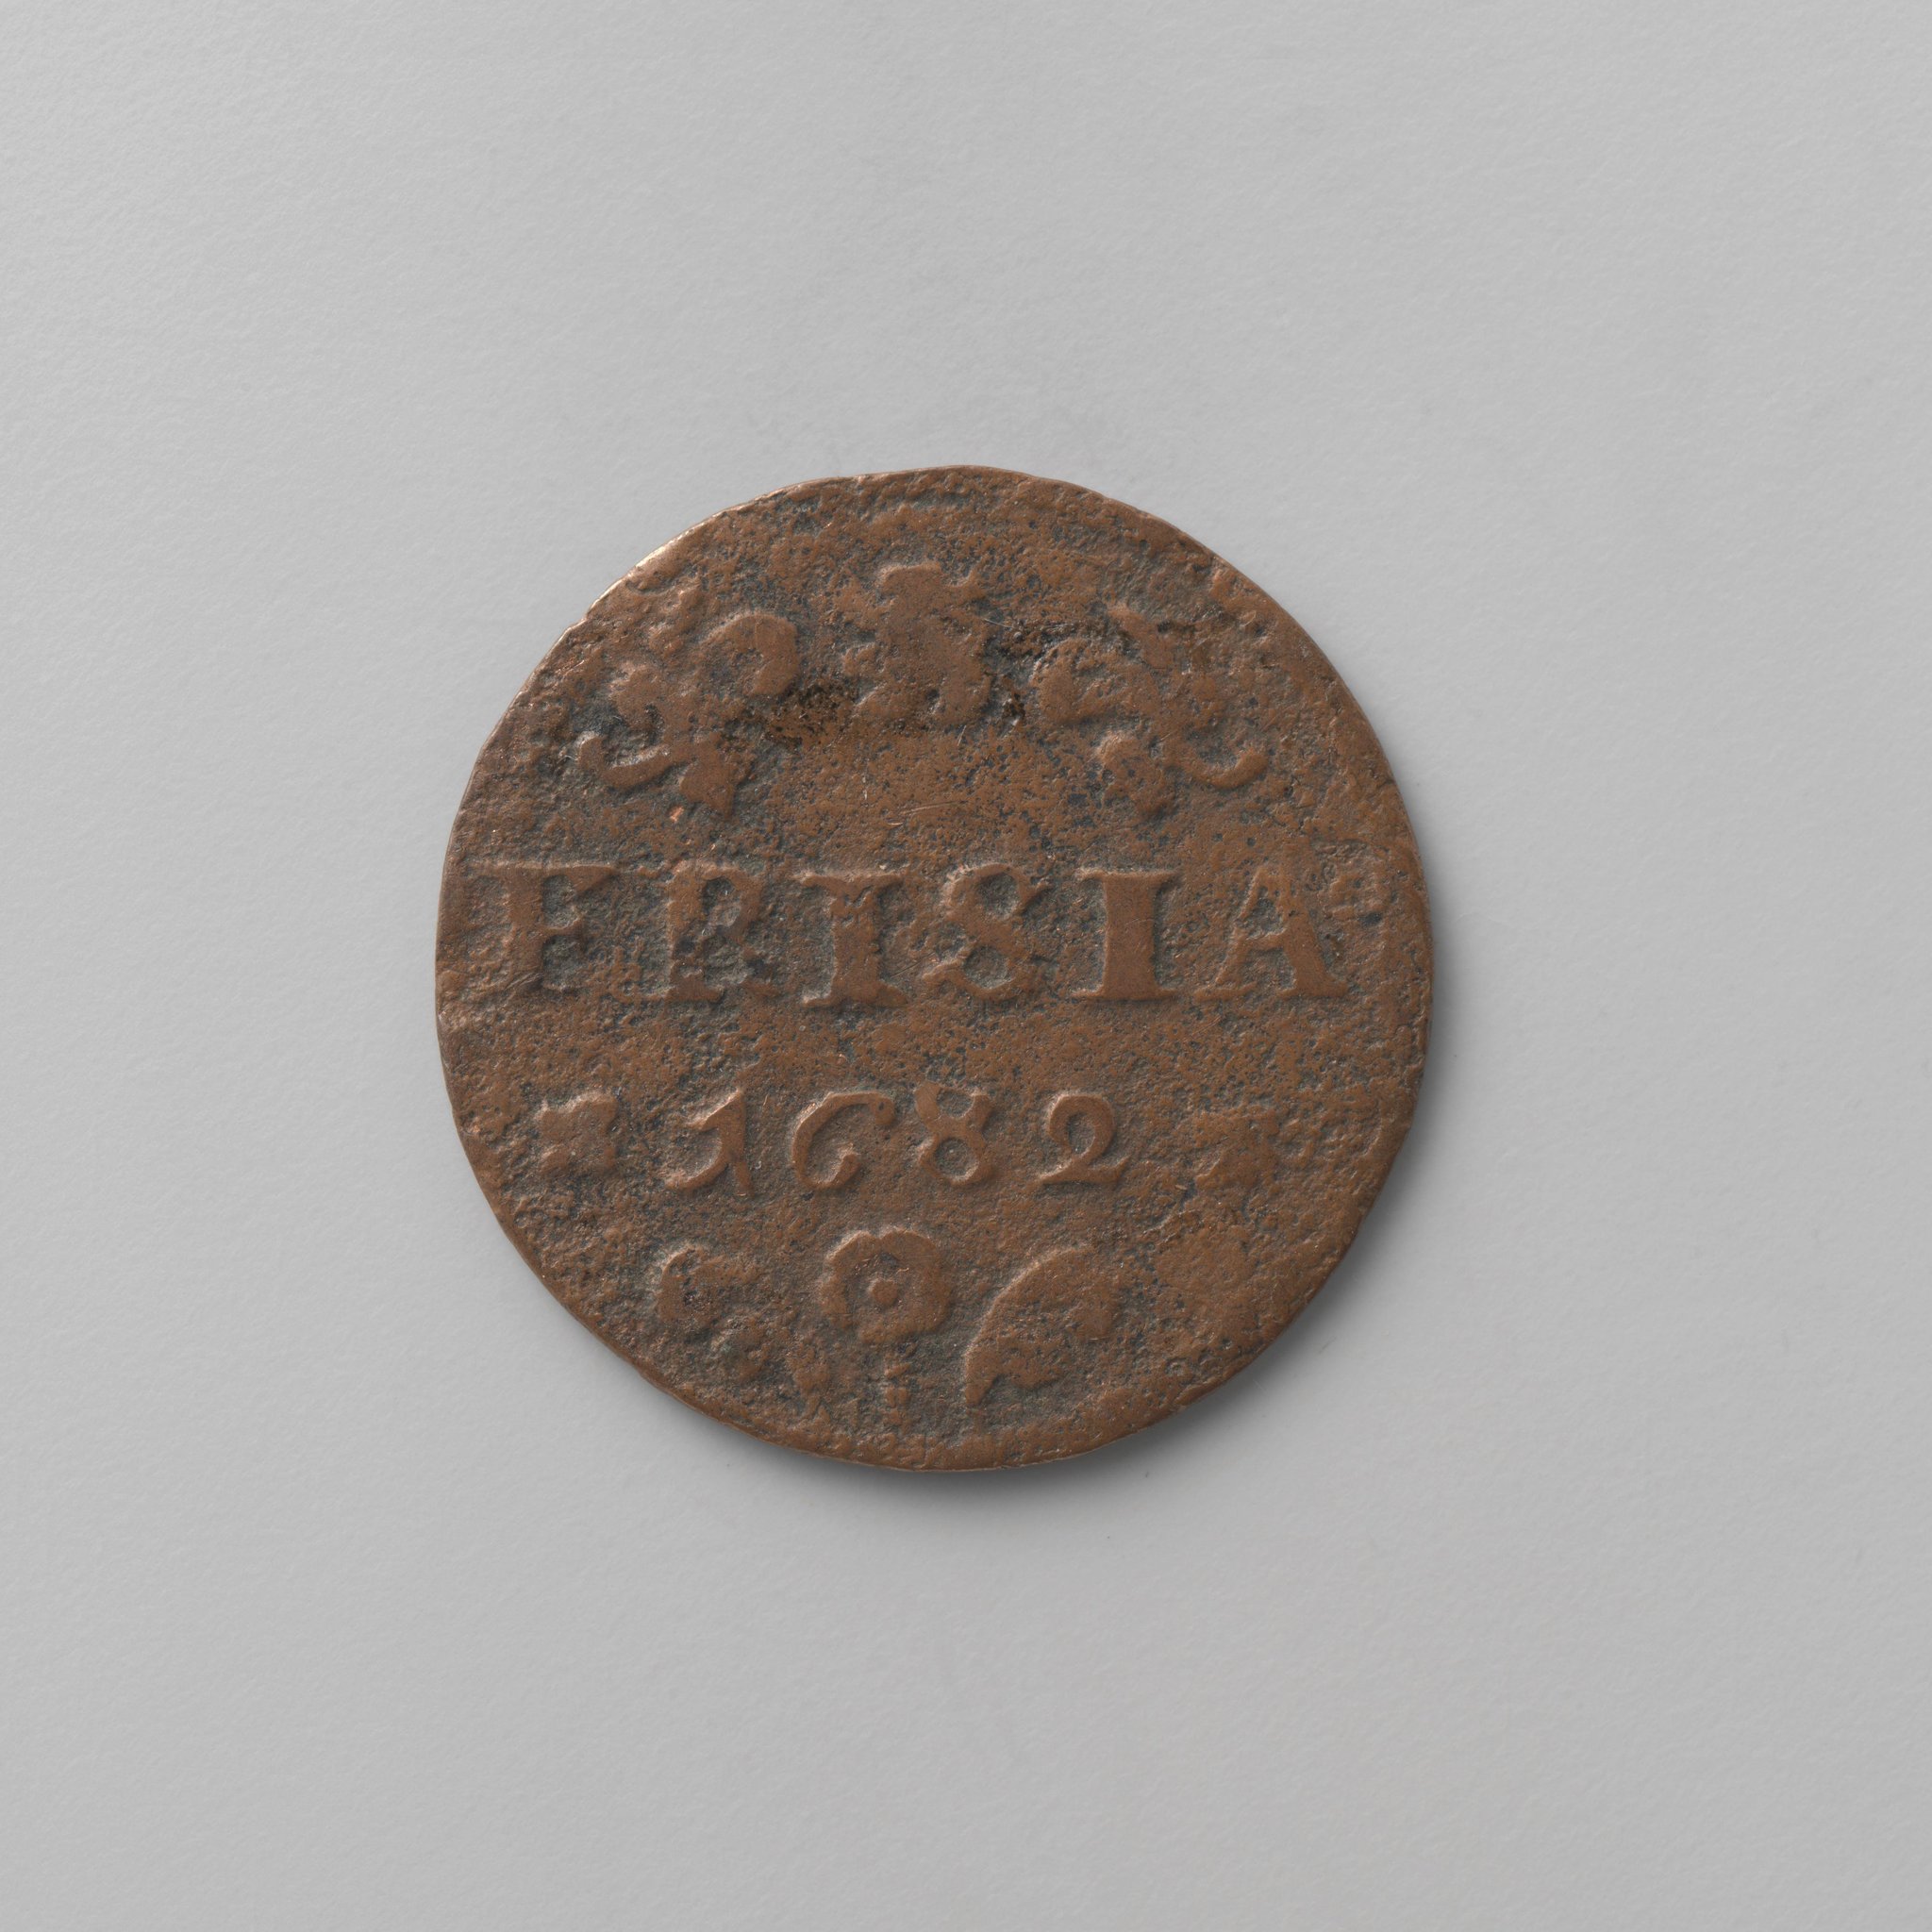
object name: zilveren dukaat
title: Zeeuwse kwart zilveren dukaat, 1765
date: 1765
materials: silver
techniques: striking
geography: middelburg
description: Zilveren munt. Voorzijde: staande geharnaste ridder naar rechts met zwaard in rechterhand en gekroond wapenschild van Zeeland aan lint in linkerhand. Keerzijde: versierd gekroond generaliteitswapenschild. Boven kroon jaartal. Kabelrand.